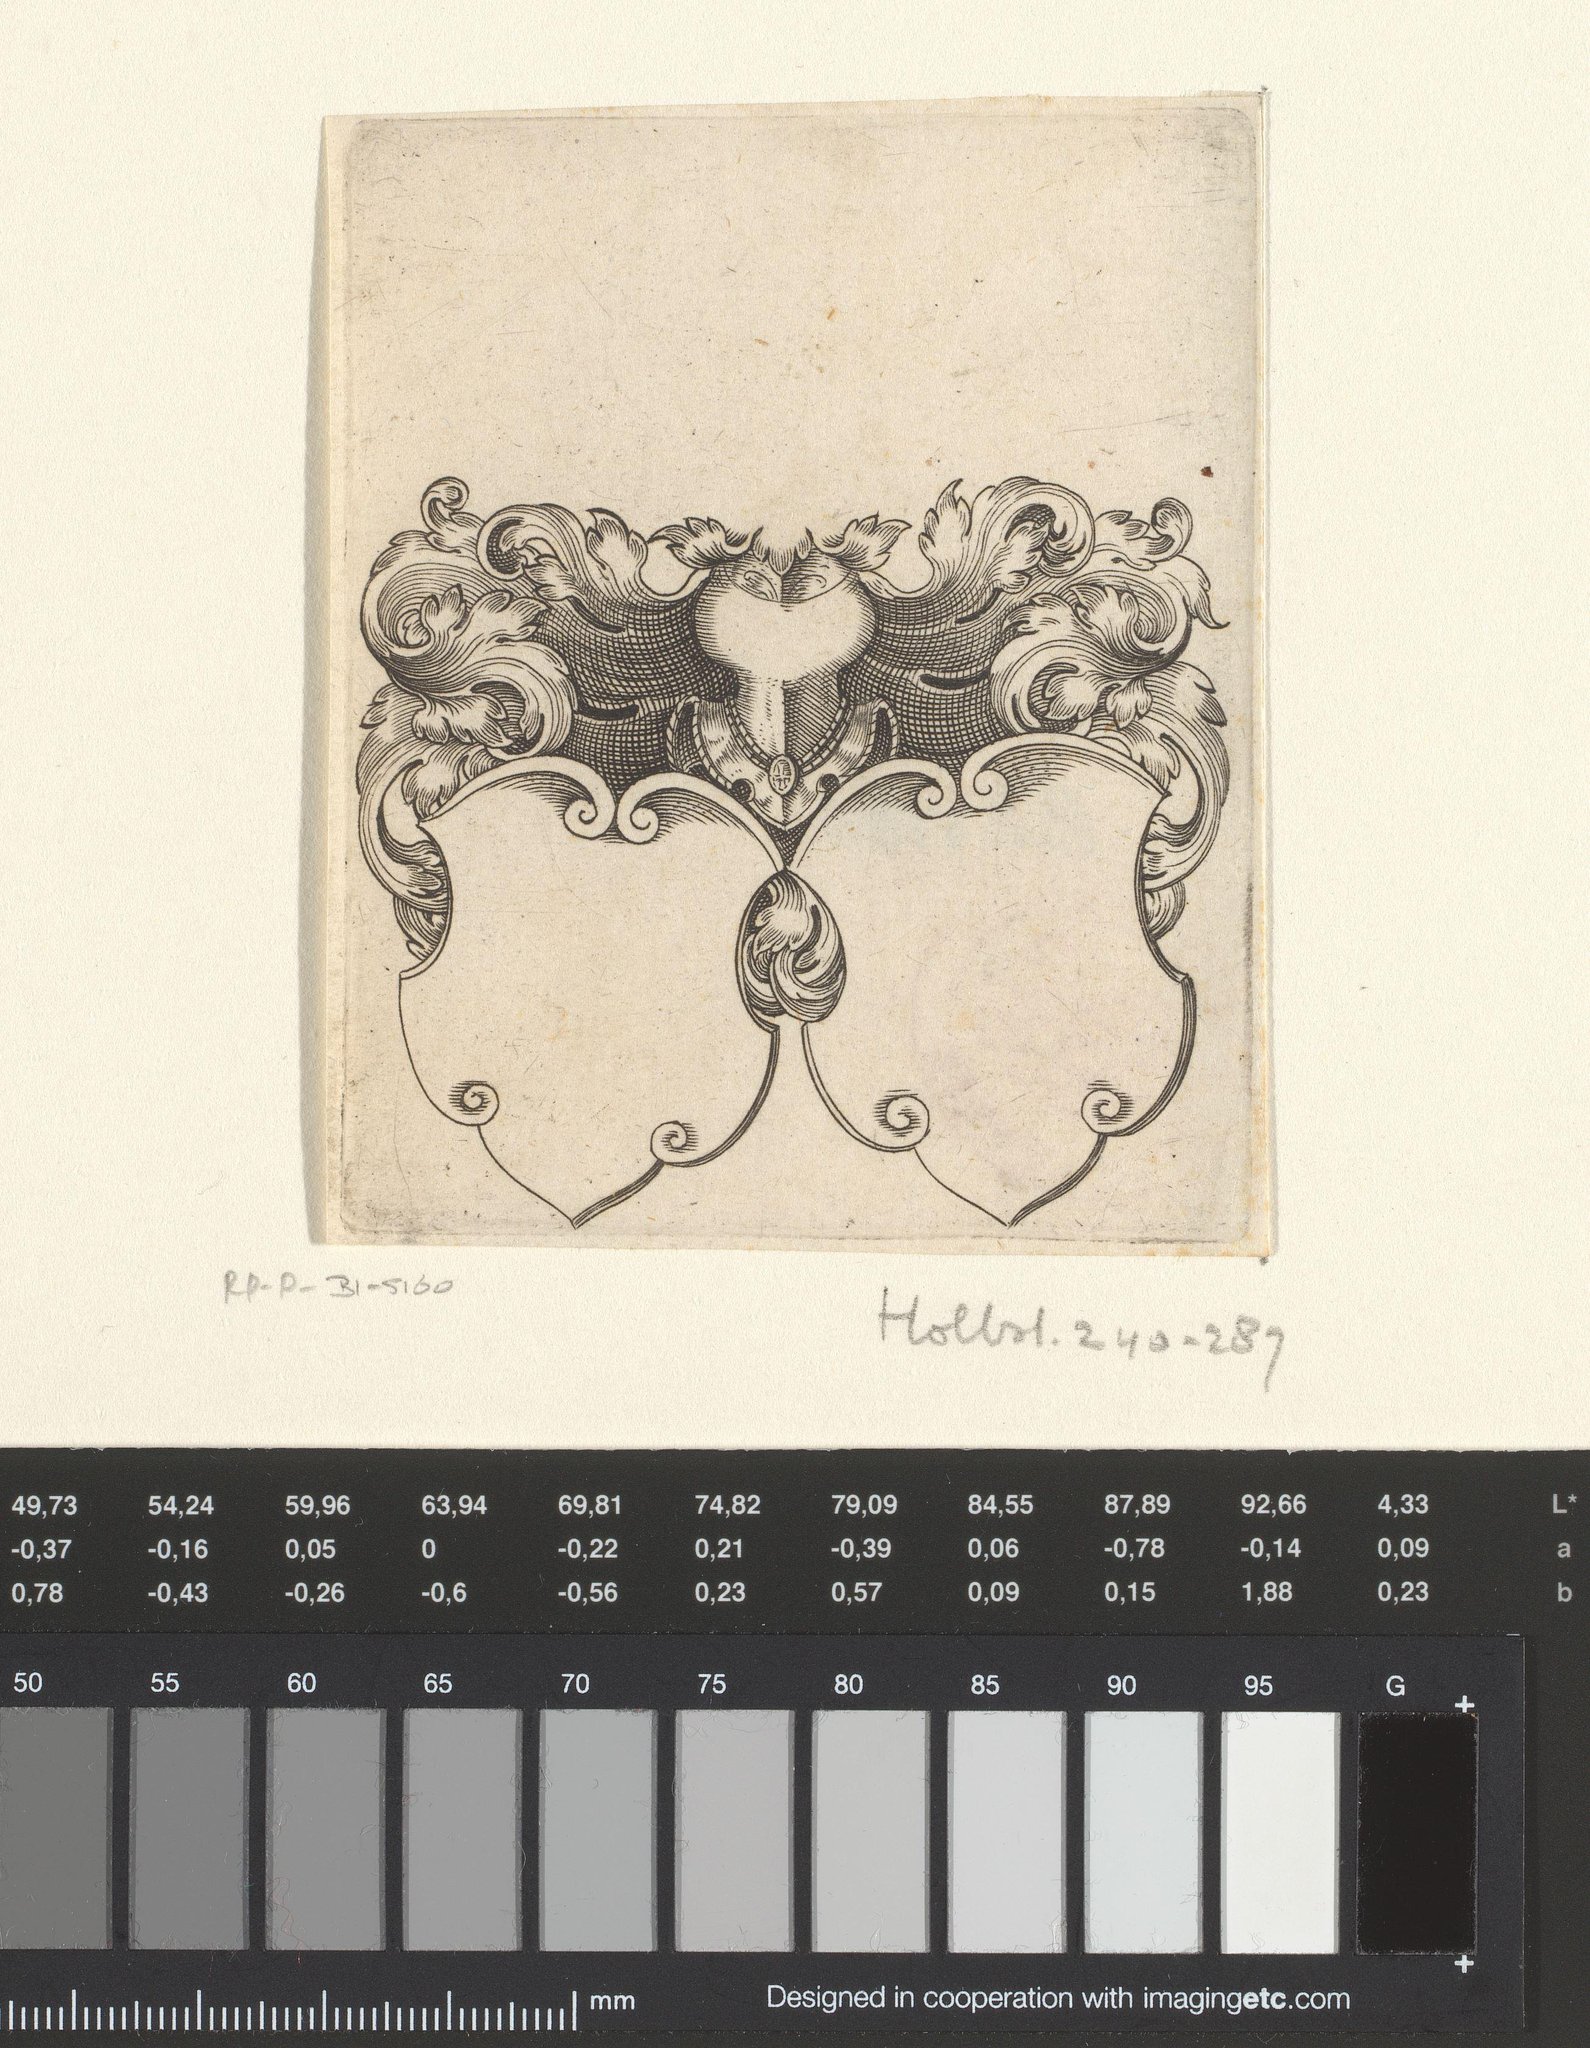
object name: print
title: Emblemata Saecularia, 1596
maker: johann theodor de bry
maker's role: print maker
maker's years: 1561-1623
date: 1596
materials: paper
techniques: engraving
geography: frankfurt am main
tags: armorial bearing, heraldry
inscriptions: collector's mark: Lugt 240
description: Afkomstig uit: Emblemata Saecularia. Mira et iucunda varietate seculi huius mores ita experimentia (...). 1e druk. Frankfurt am Main: J.T. de Bry en J.I. de Bry, 1596.